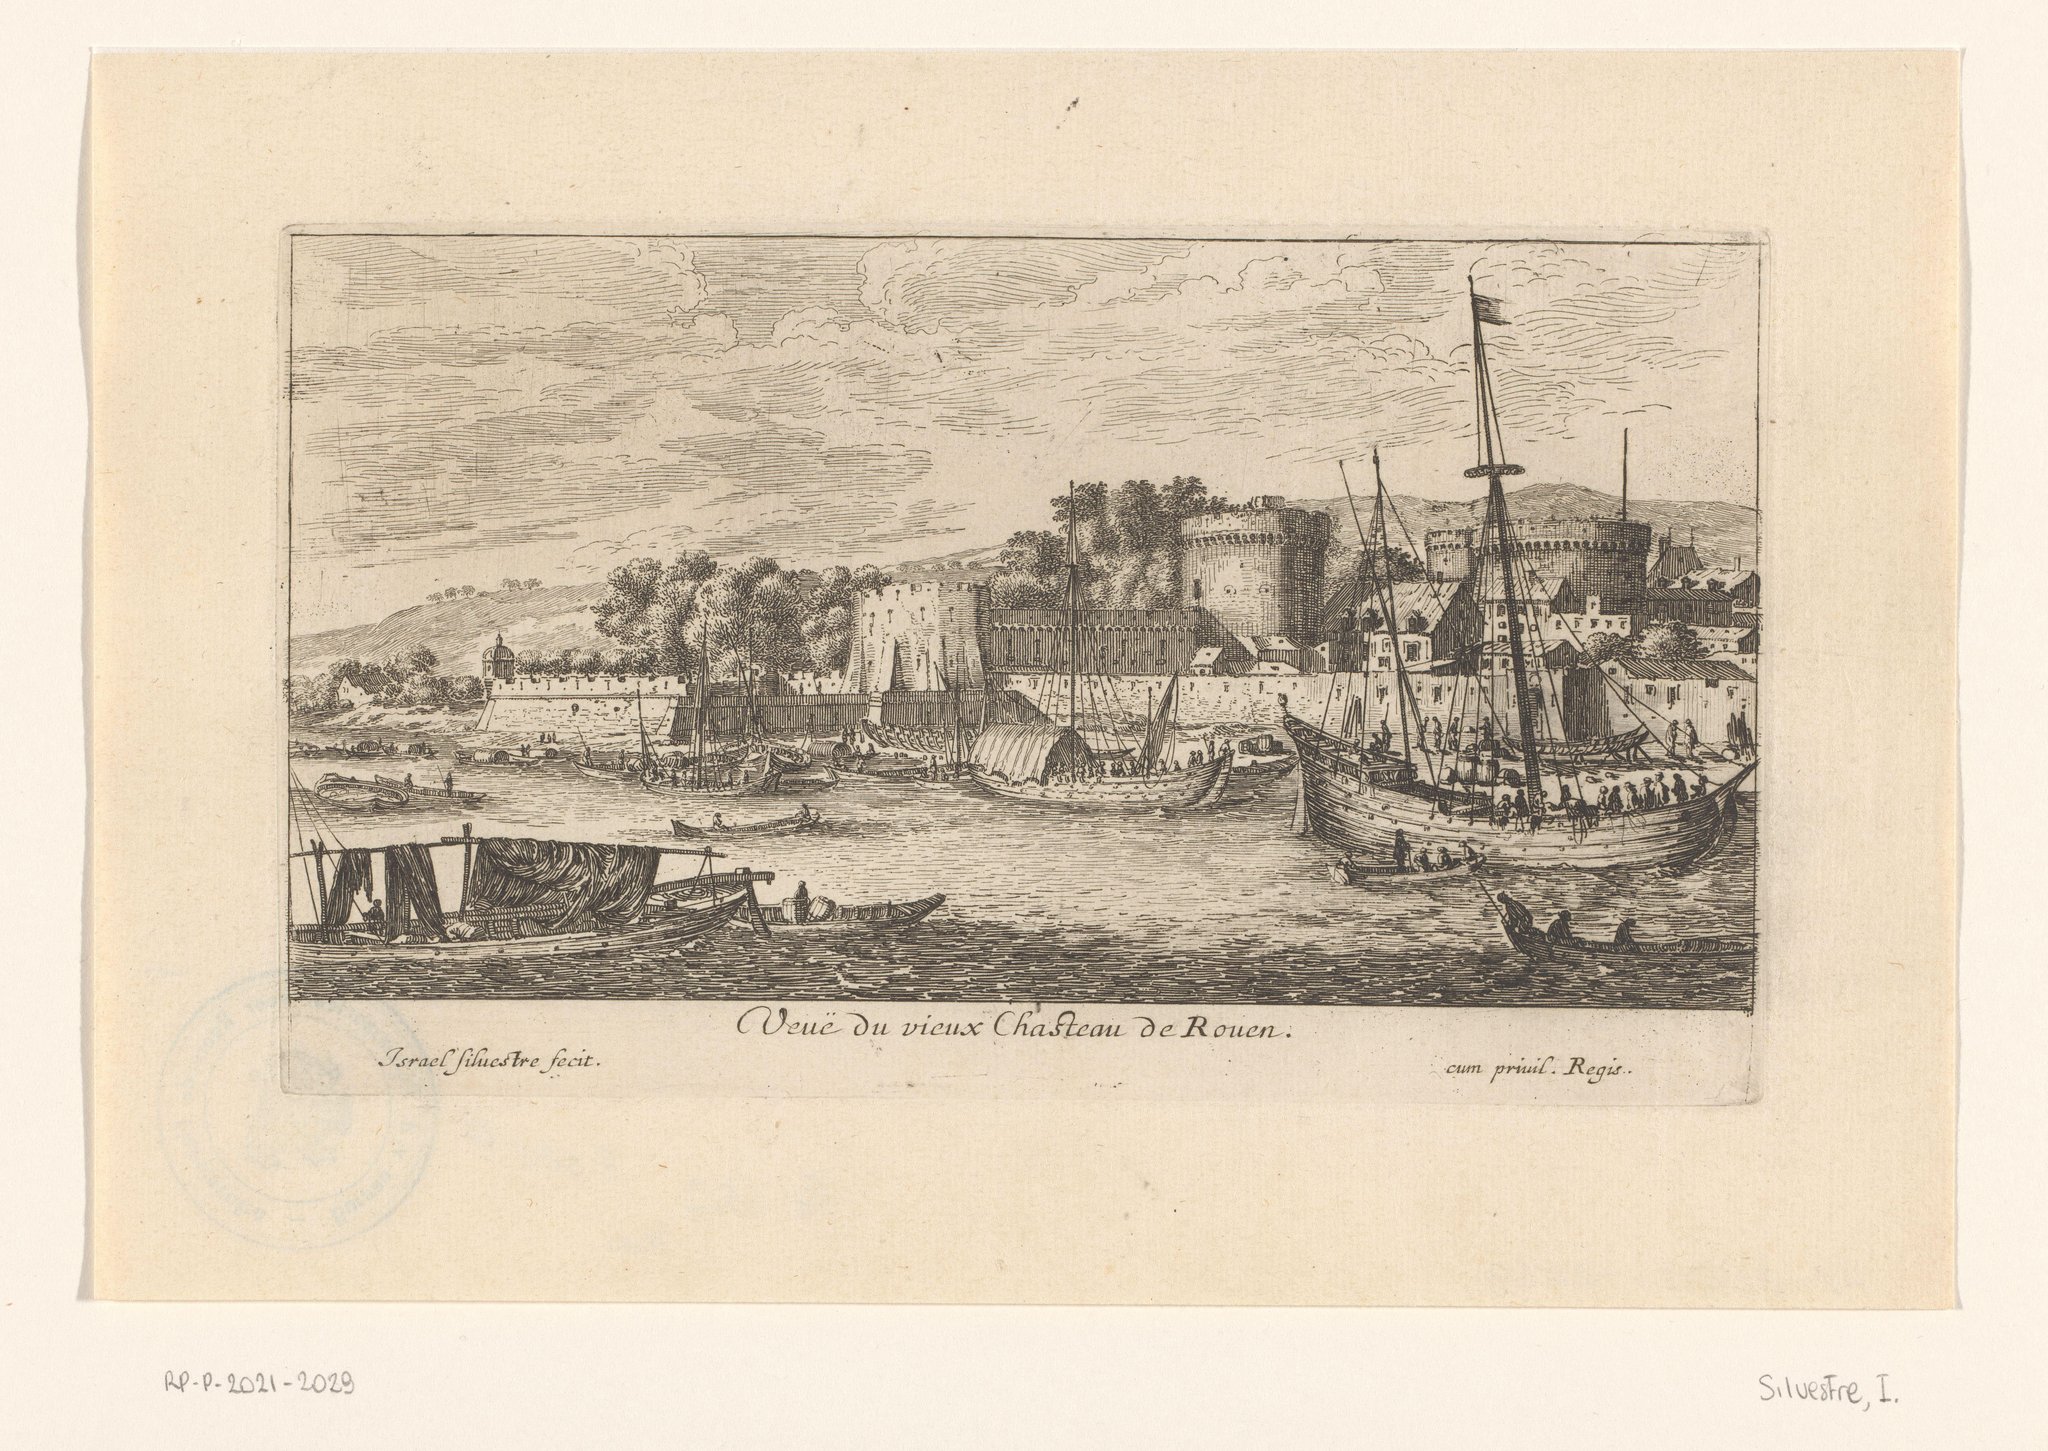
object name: print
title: Veuë du vieux Chasteau de Rouen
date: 1657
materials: paper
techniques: etching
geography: france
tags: sailing-ship, sailing-boat, landscape with tower or castle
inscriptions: stamp: ‘Bureau v.d. Rijksinspecteur voor Roerende Monumenten ’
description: Prent maakt deel uit van een ongenummerde serie van negen prenten.